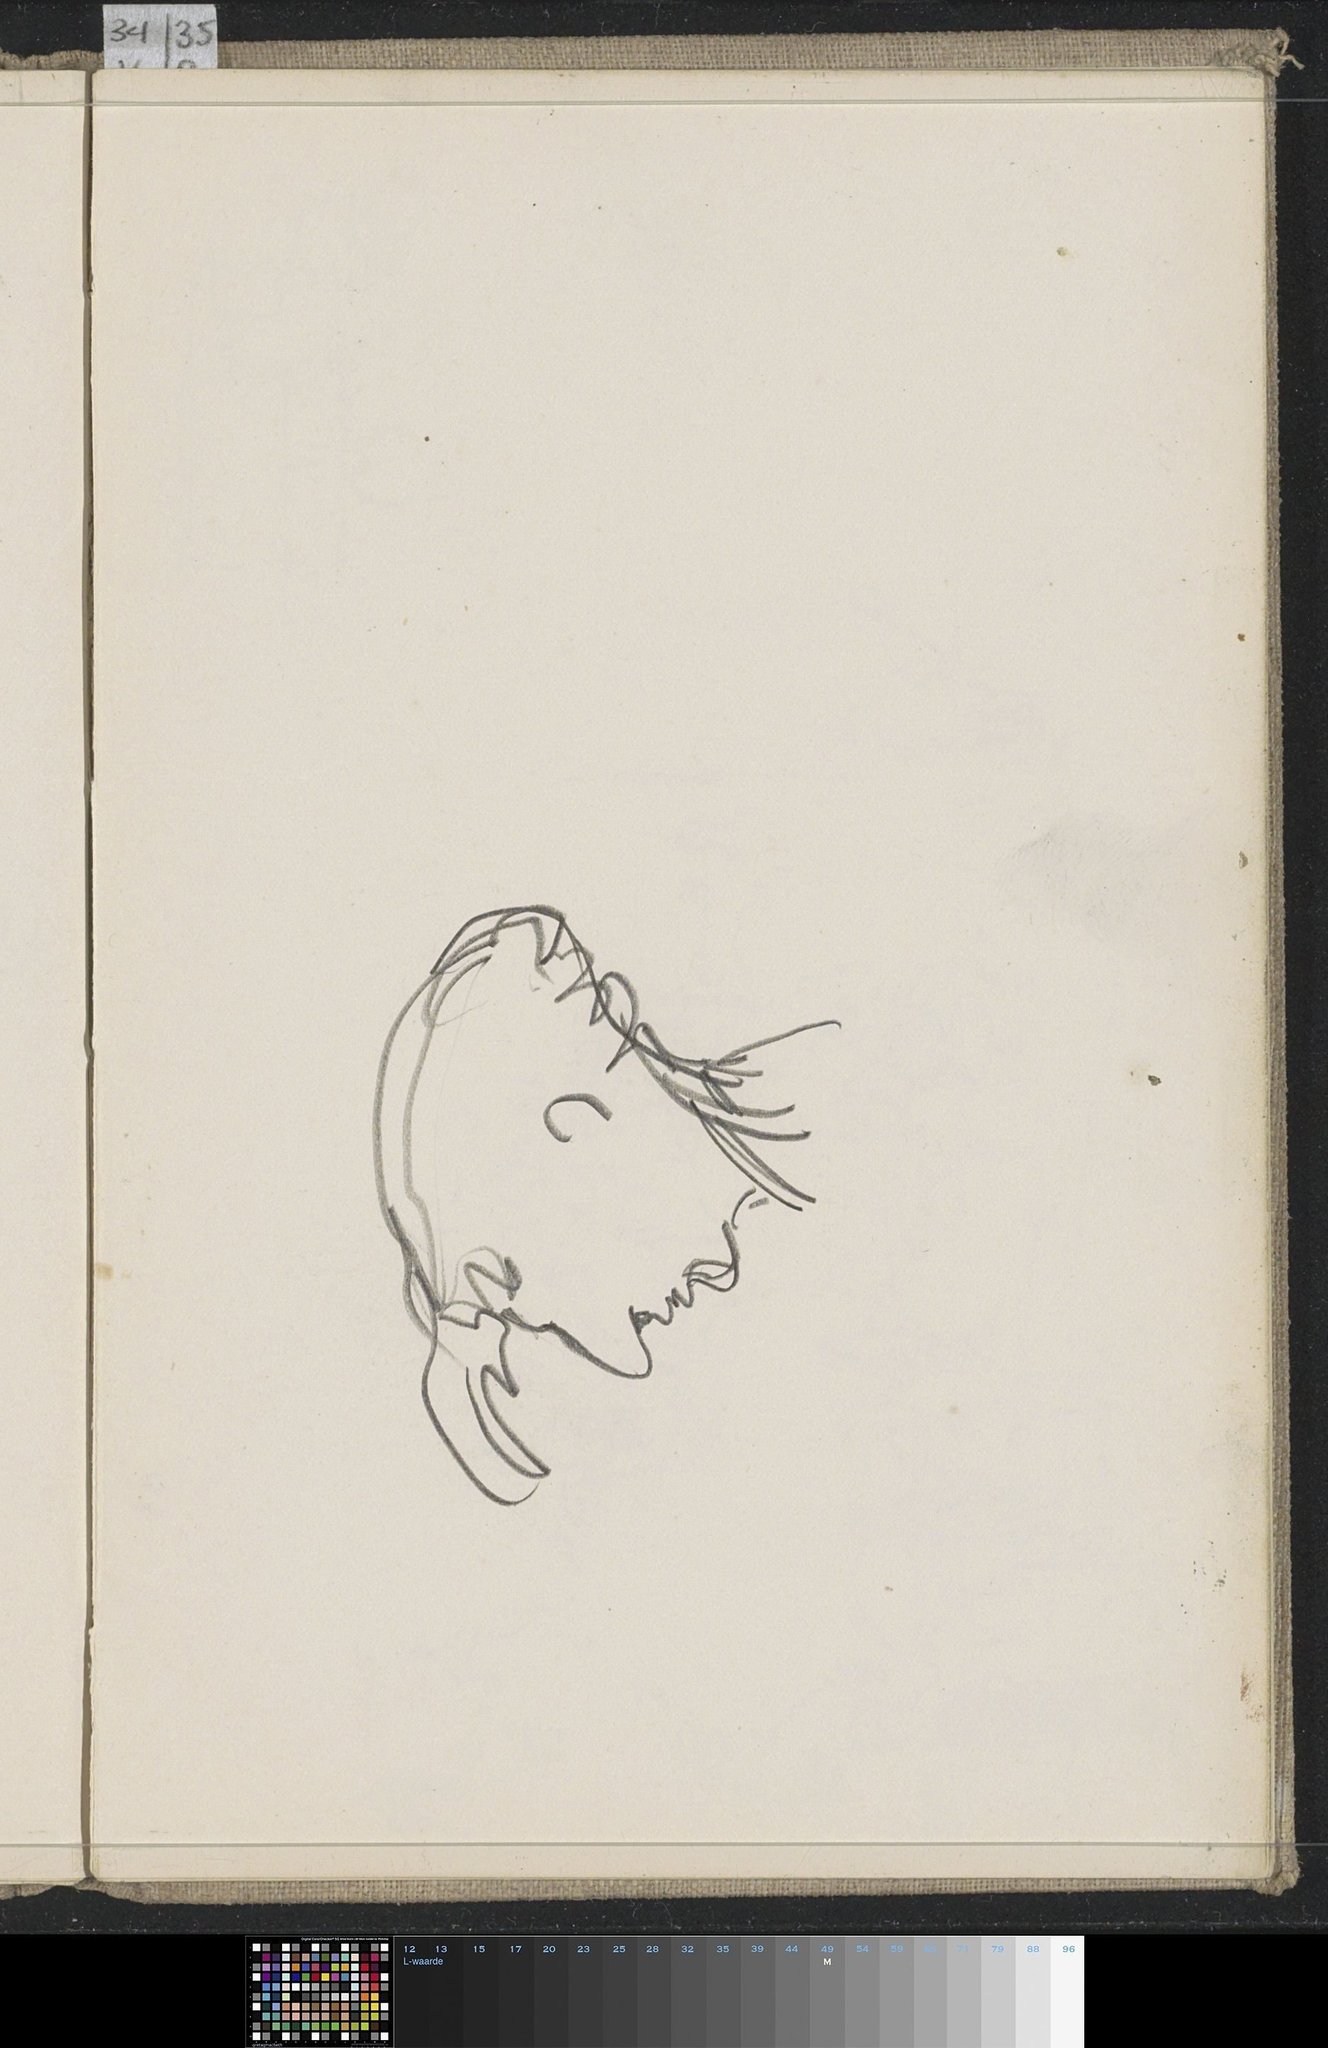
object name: sketchbook leaf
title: Karikaturale kop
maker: cornelis vreedenburgh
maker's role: draughtsman, print maker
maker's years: 1880-1946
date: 1890-1946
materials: paper, pencil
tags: head (human)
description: Blad 33 recto uit een schetsboek met 41 bladen.